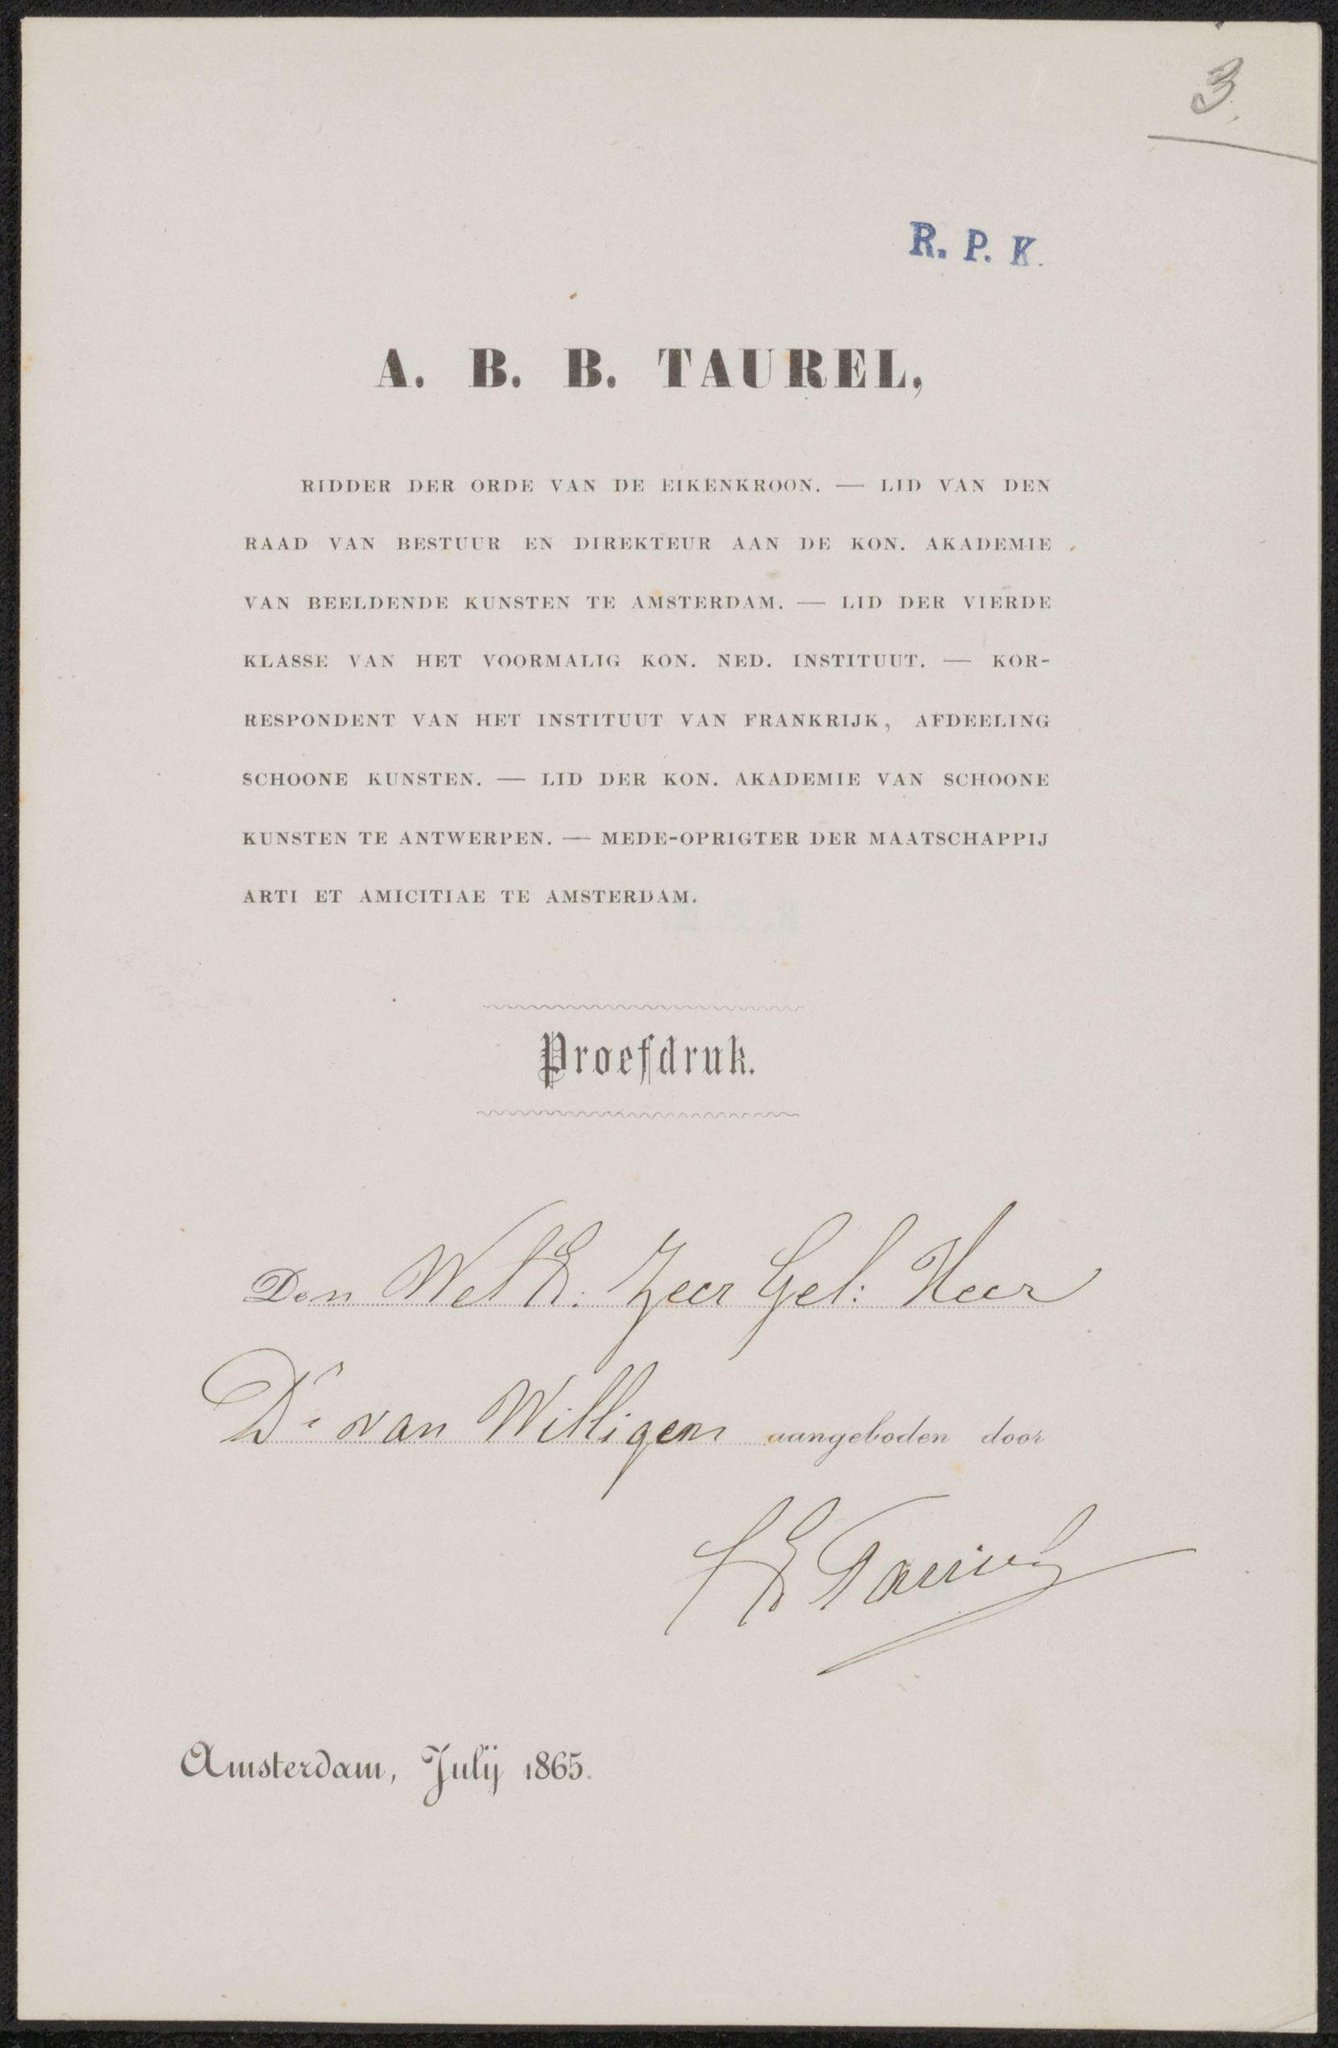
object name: document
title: Proefdruk aan D. van Willigen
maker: edouard taurel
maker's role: draughtsman, print maker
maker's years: 1824-1892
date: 1807-1865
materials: ink, paper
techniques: pen, printing, writing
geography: amsterdam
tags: benoit taurel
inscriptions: collector's mark: Lugt 2233